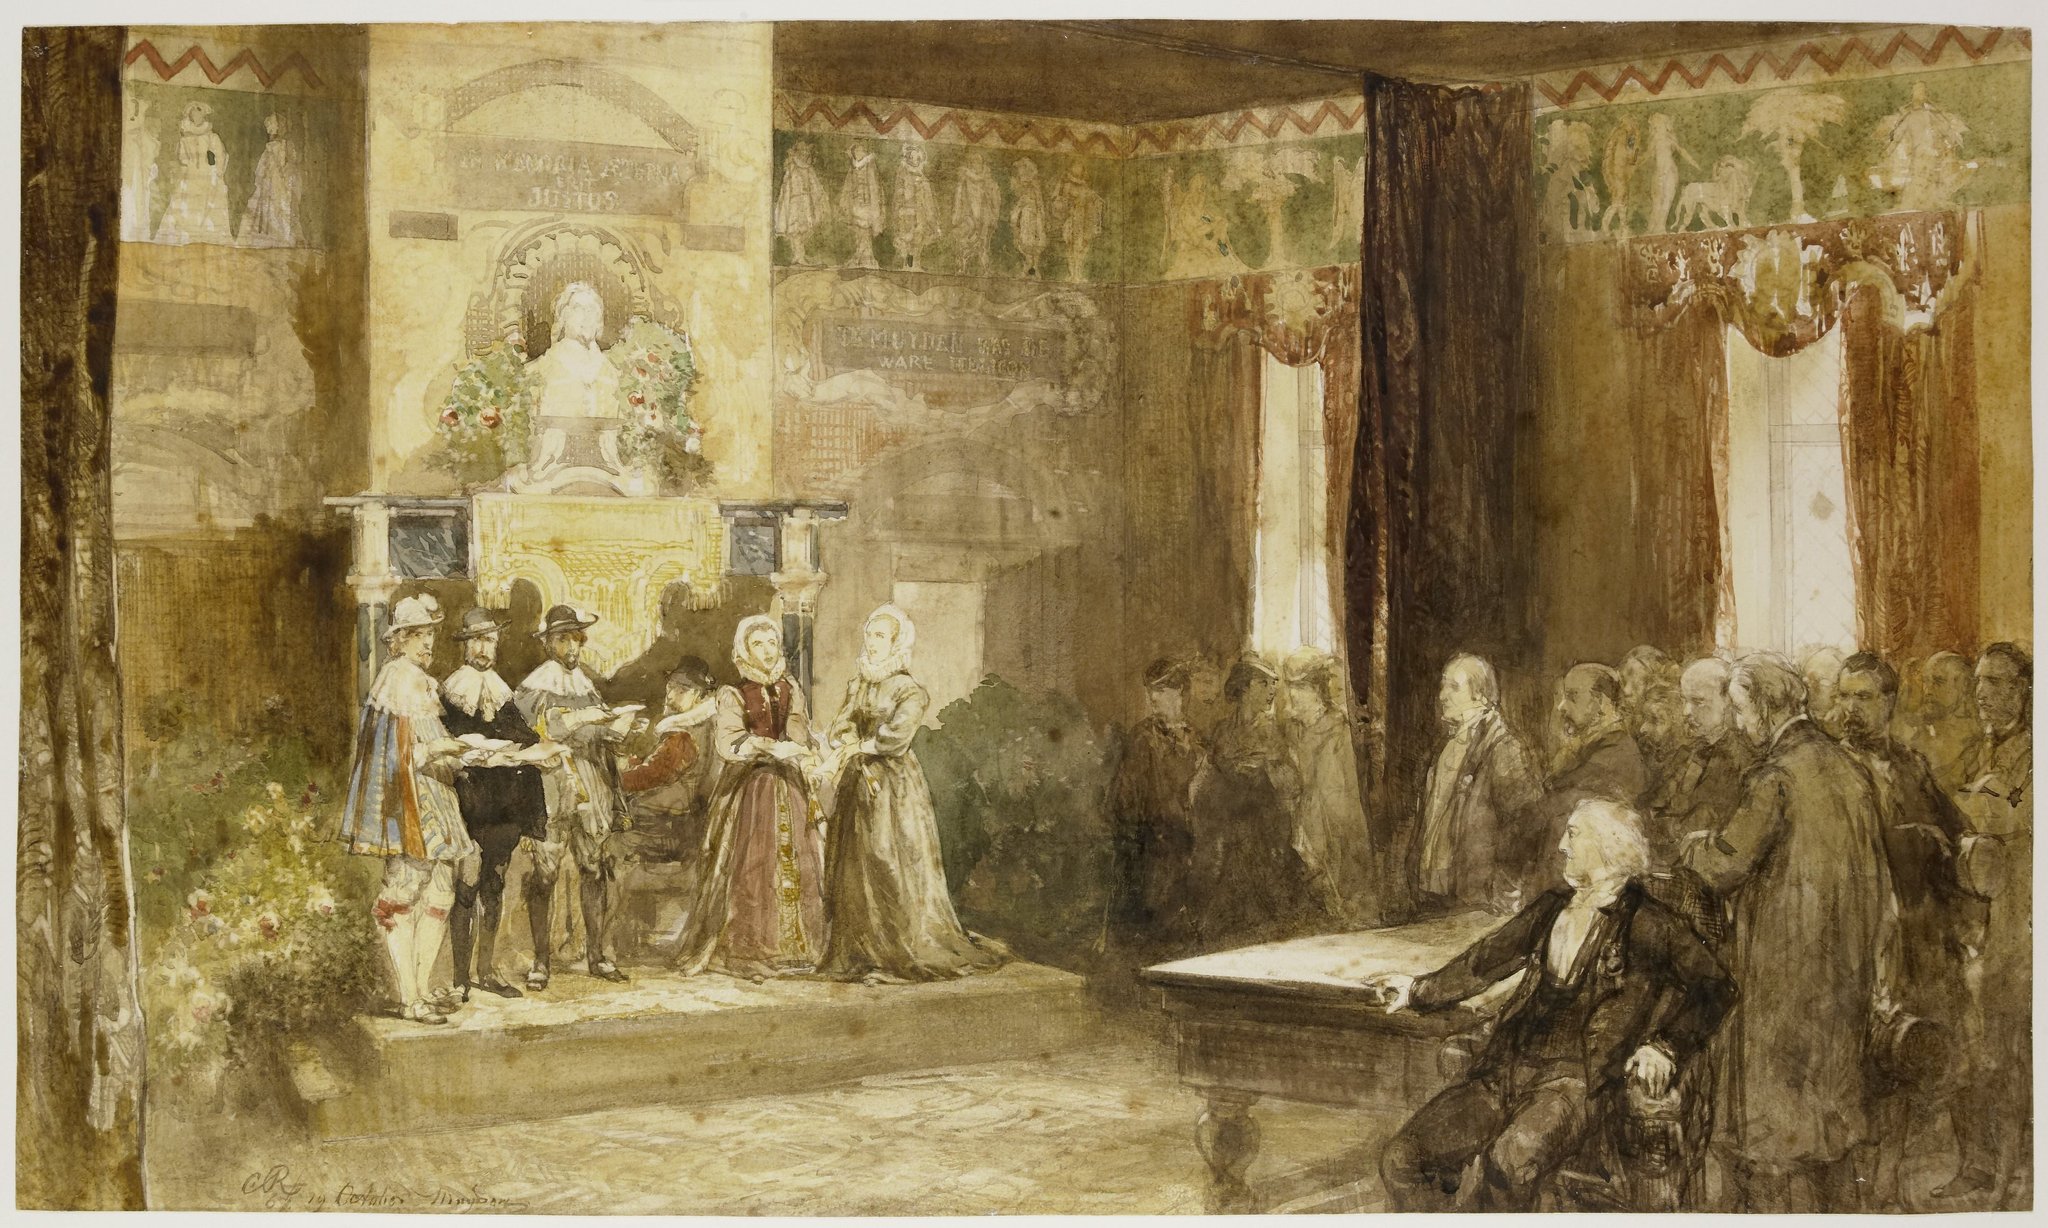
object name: watercolor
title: Vondelviering op het Muiderslot, 1867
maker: charles rochussen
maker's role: draughtsman, painter, print maker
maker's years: 1814-1894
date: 1867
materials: paper, pencil, watercolor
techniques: brush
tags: mechelen, amsterdam, sculptor, louis royer, jacob van lennep, publisher, josephus albertus alberdingk thijm, cologne, joost van den vondel, politician, commemoration of an artist, historical persons, writer, poet, author, historical events and situations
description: Vondel-Viering op het Muiderslot, 19 october 1867, Muiden. Op de voorgrond Jacob van Lennep, voorts Jhr. Bicker, W. Hofdijk, L. Royer en J.A. Alberdingk Thijm.